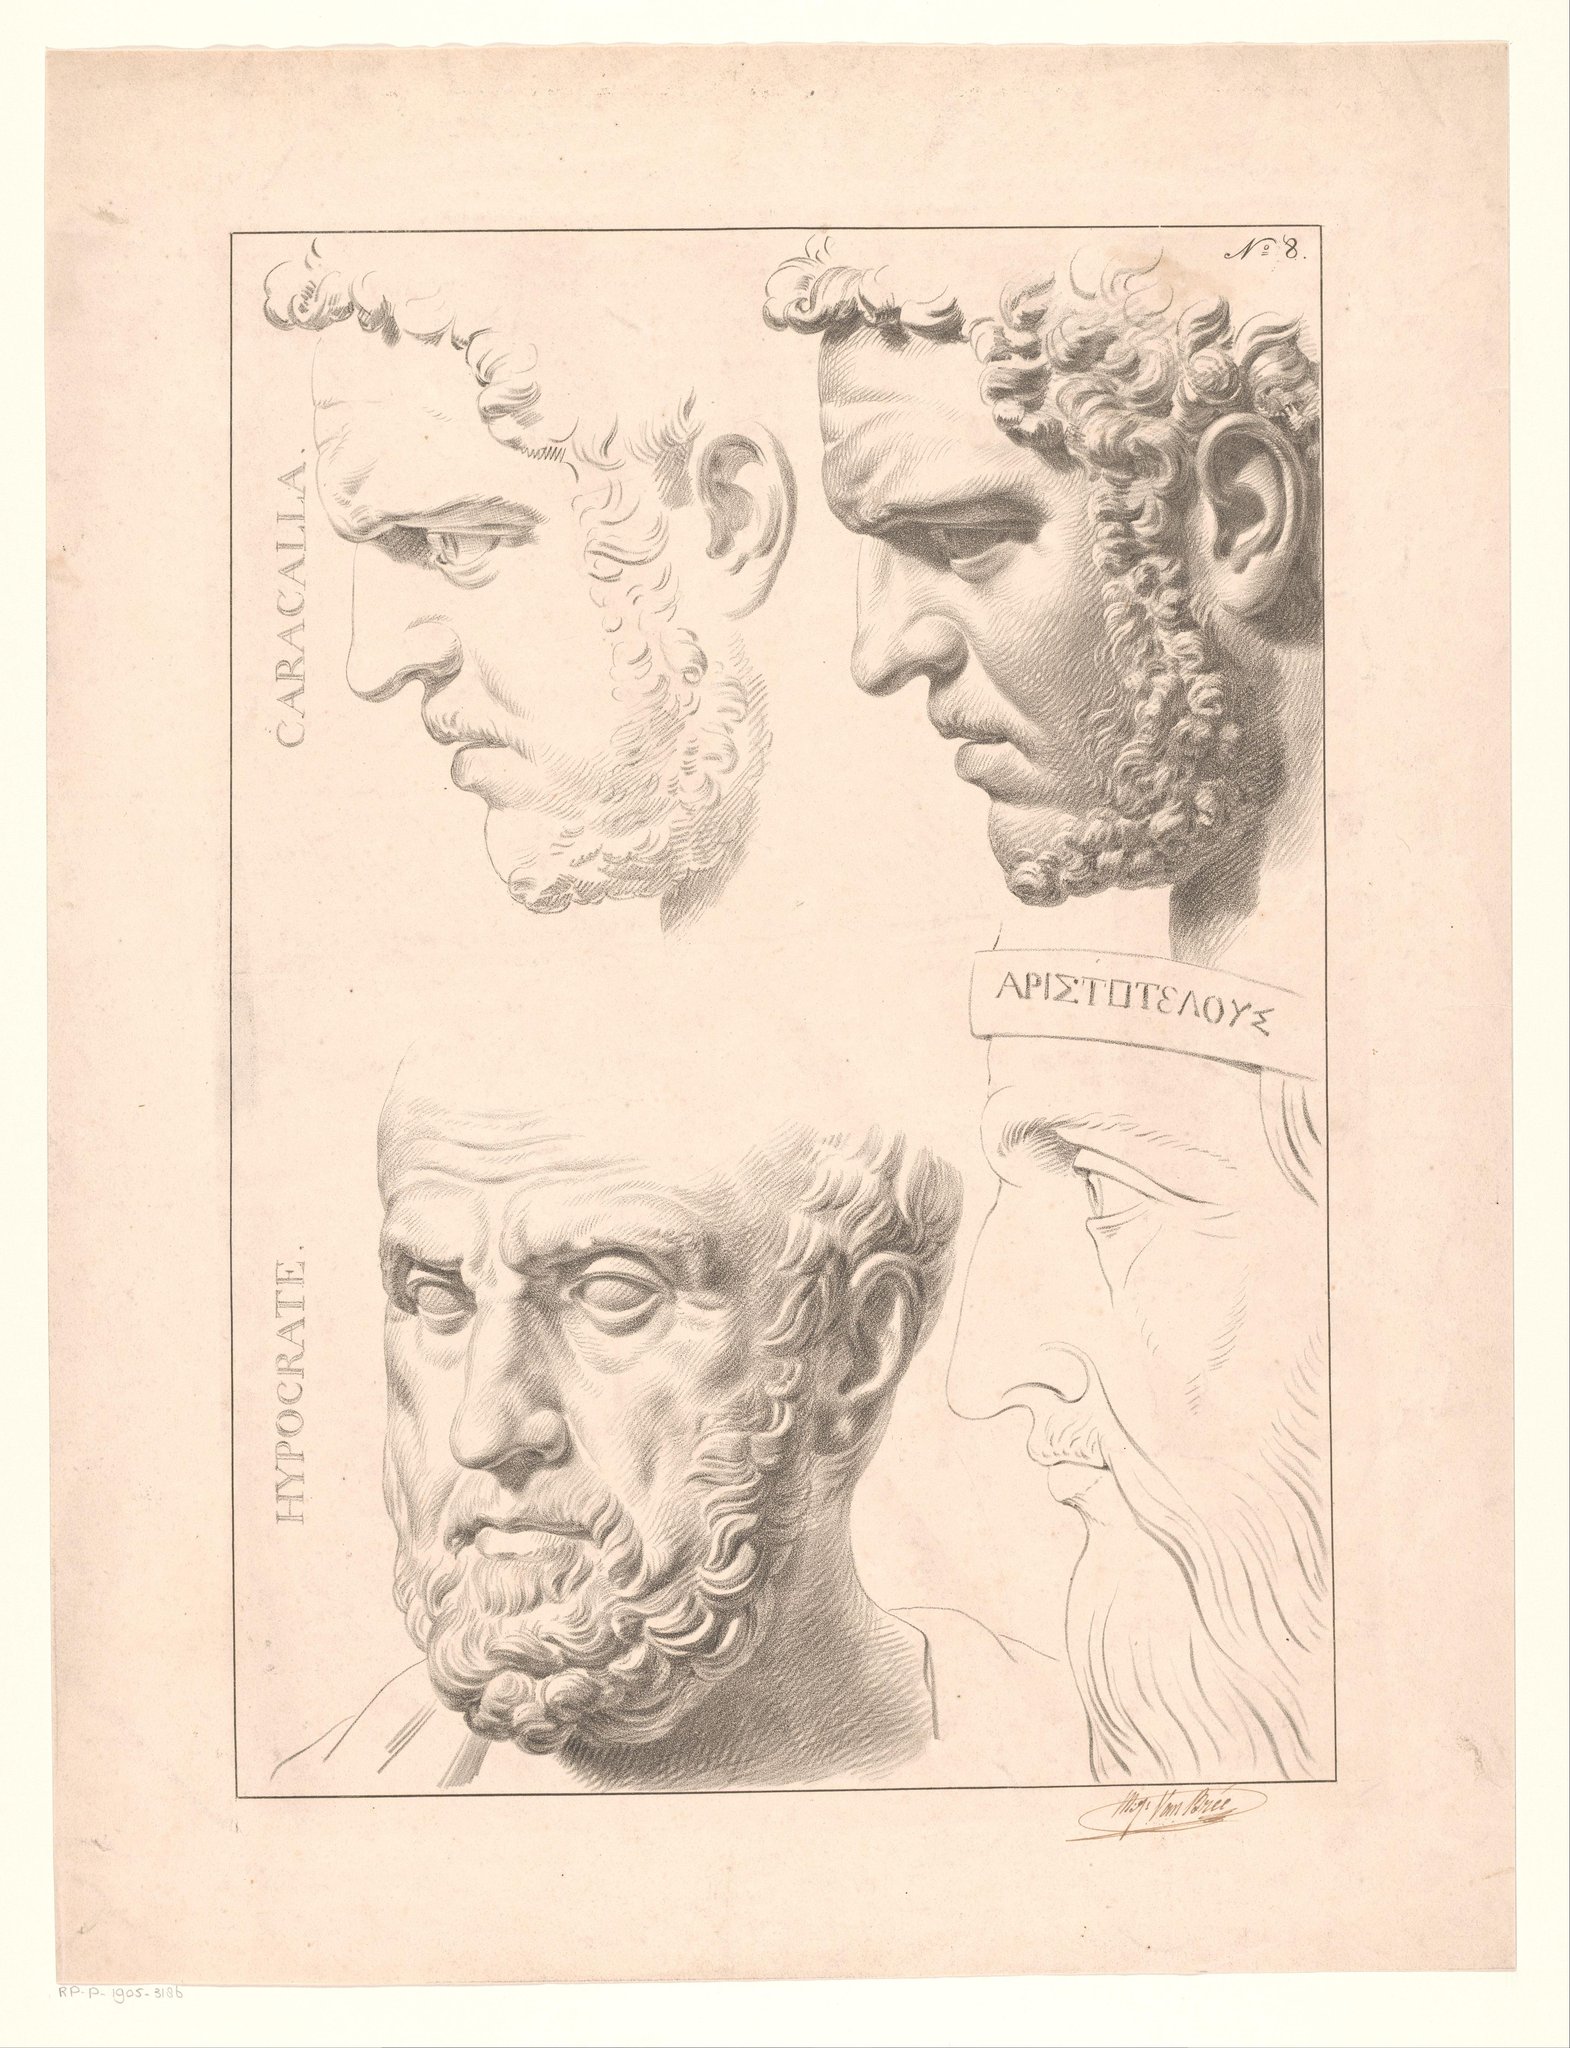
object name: print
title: Caracalla / Hypocrate / ΑΡΙΣΤΟΤΕΛOYΣ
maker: mattheus ignatius van bree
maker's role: draughtsman, print maker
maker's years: 1773-1839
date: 1809-1839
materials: paper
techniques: lithograph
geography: antwerp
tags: aristotle, (story of) hippocrates, (story of) caracalla, the roman emperor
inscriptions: collector's mark: Lugt 2228